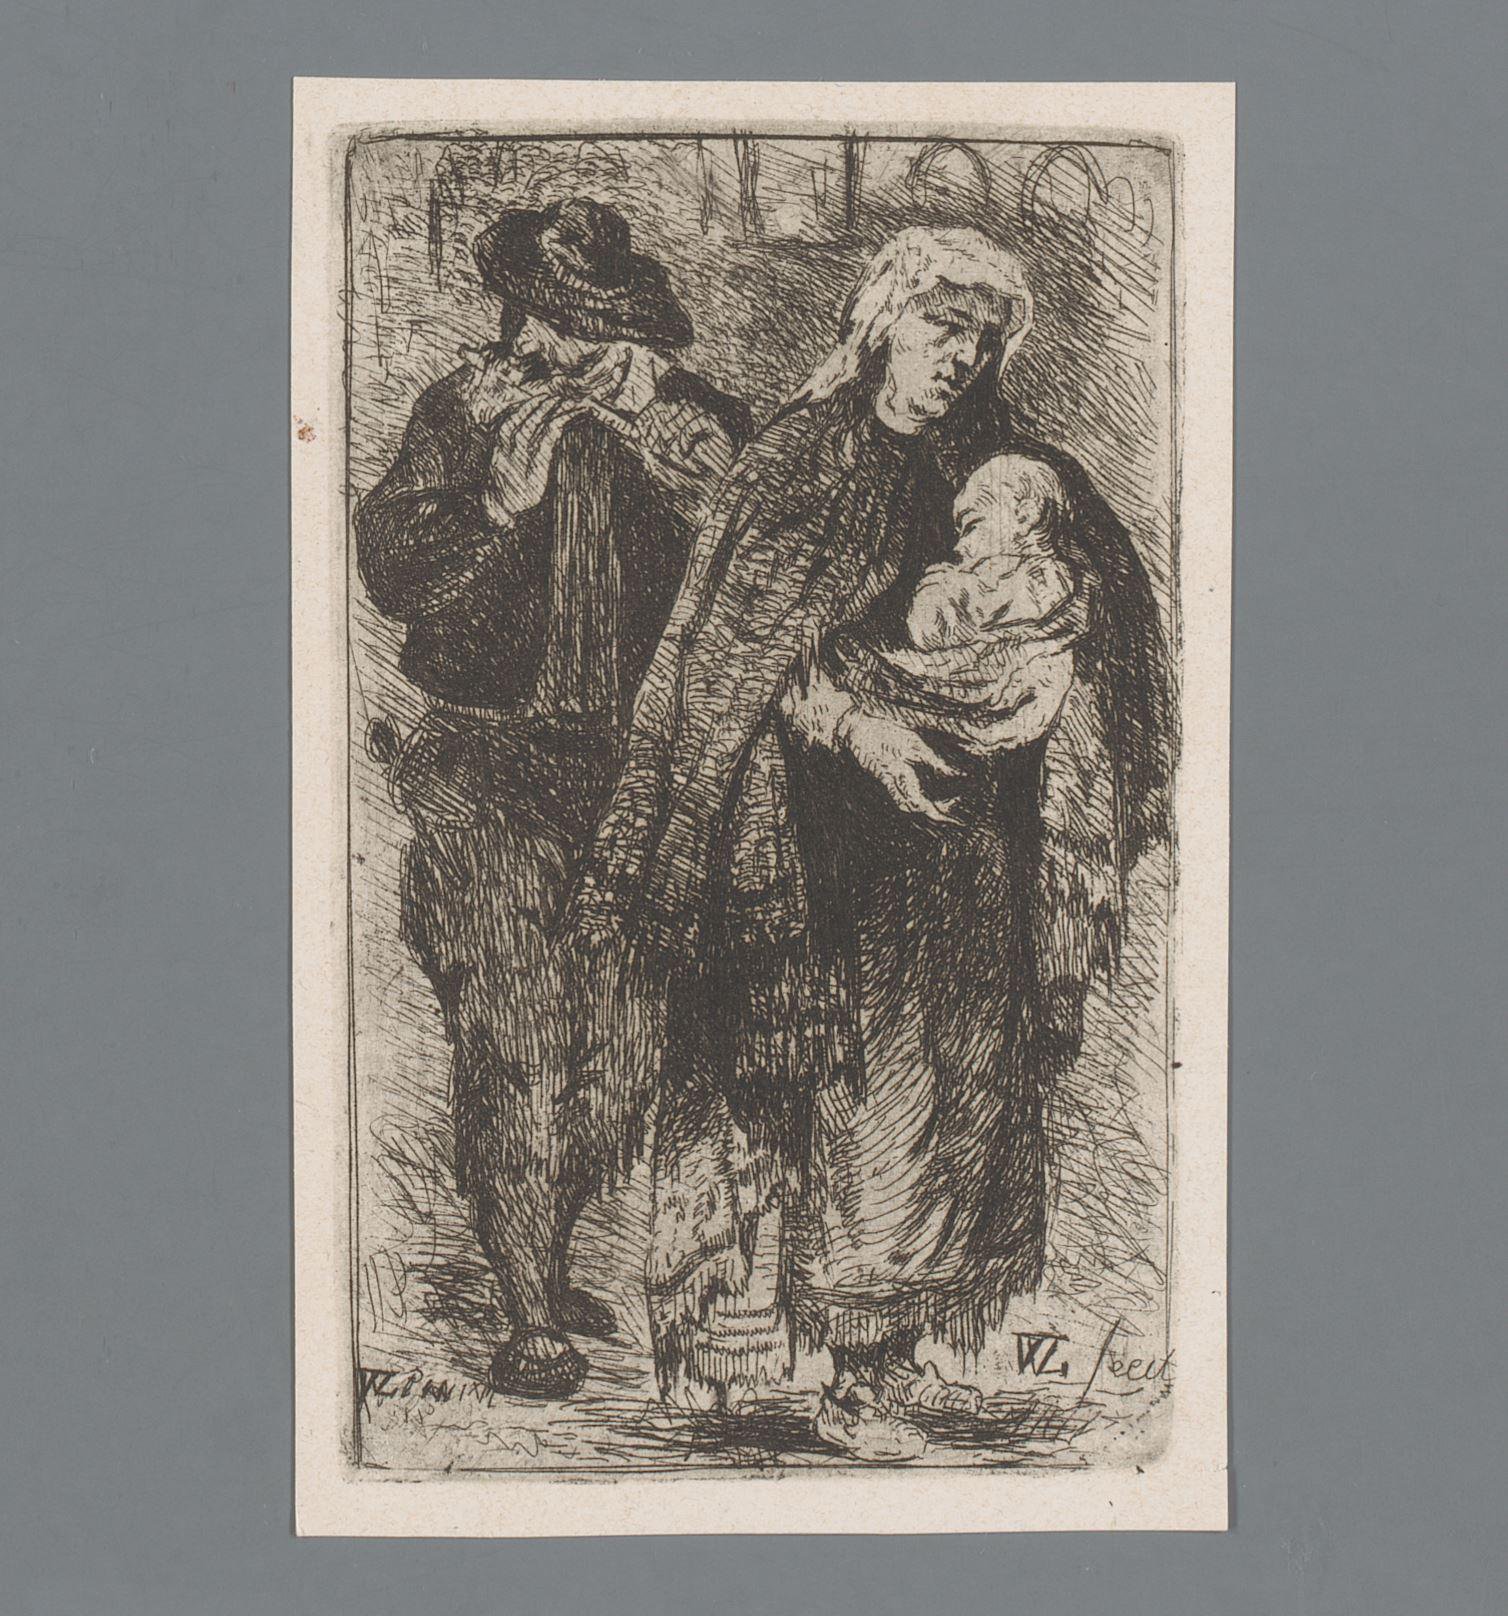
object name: print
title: Vrouw met baby en man met fluit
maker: willem linnig (ii)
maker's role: print maker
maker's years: 1842-1890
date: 1852-1890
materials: paper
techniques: etching, intaglio, letterpress printing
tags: transverse flute - cc - out of doors, mother and baby or young child